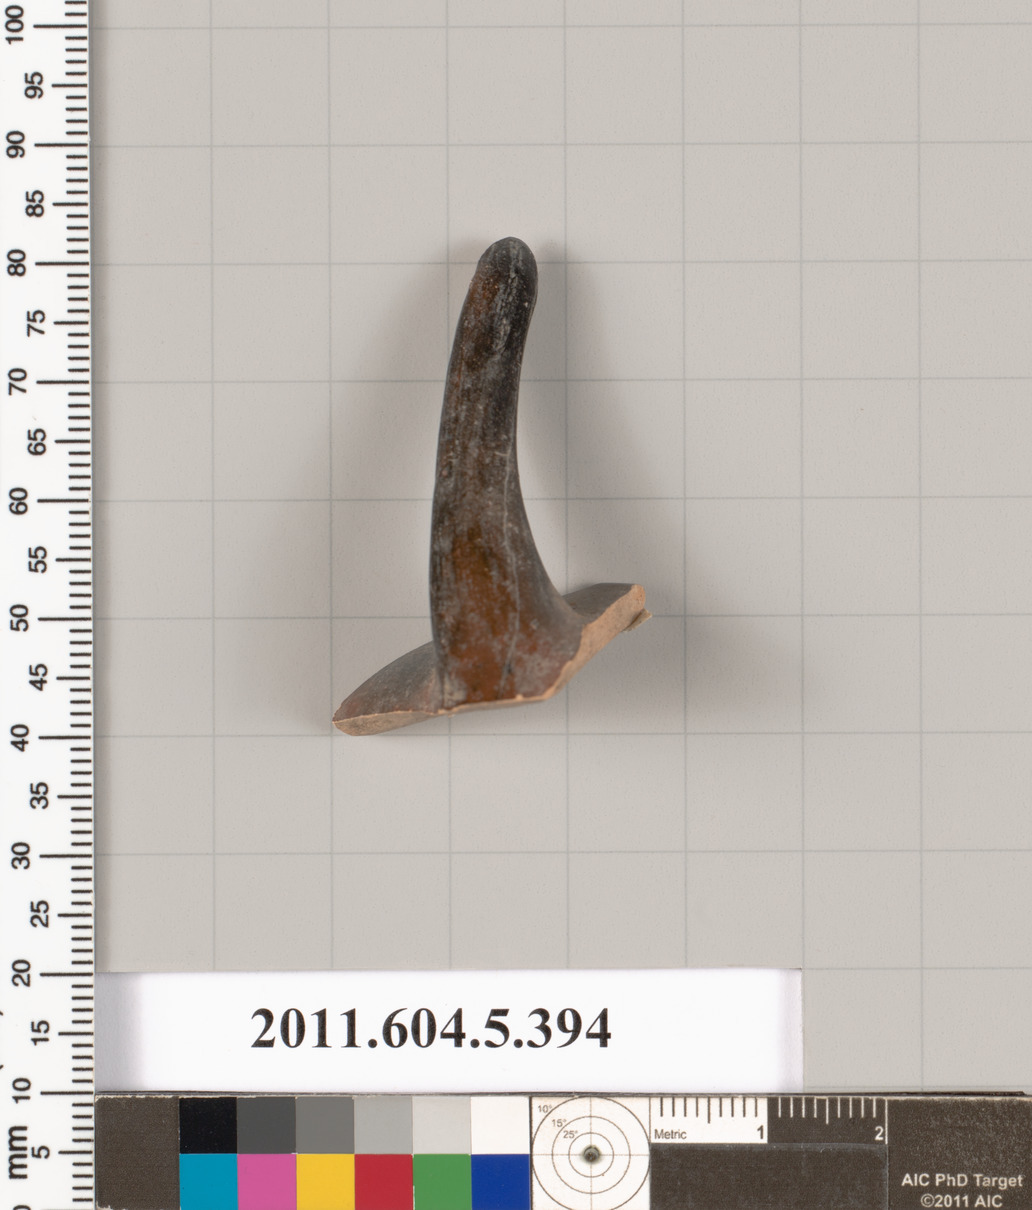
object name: kylix fragment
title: Terracotta rim fragment of a kylix (drinking cup)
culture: greek, attic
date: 600-401 BCE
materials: terracotta